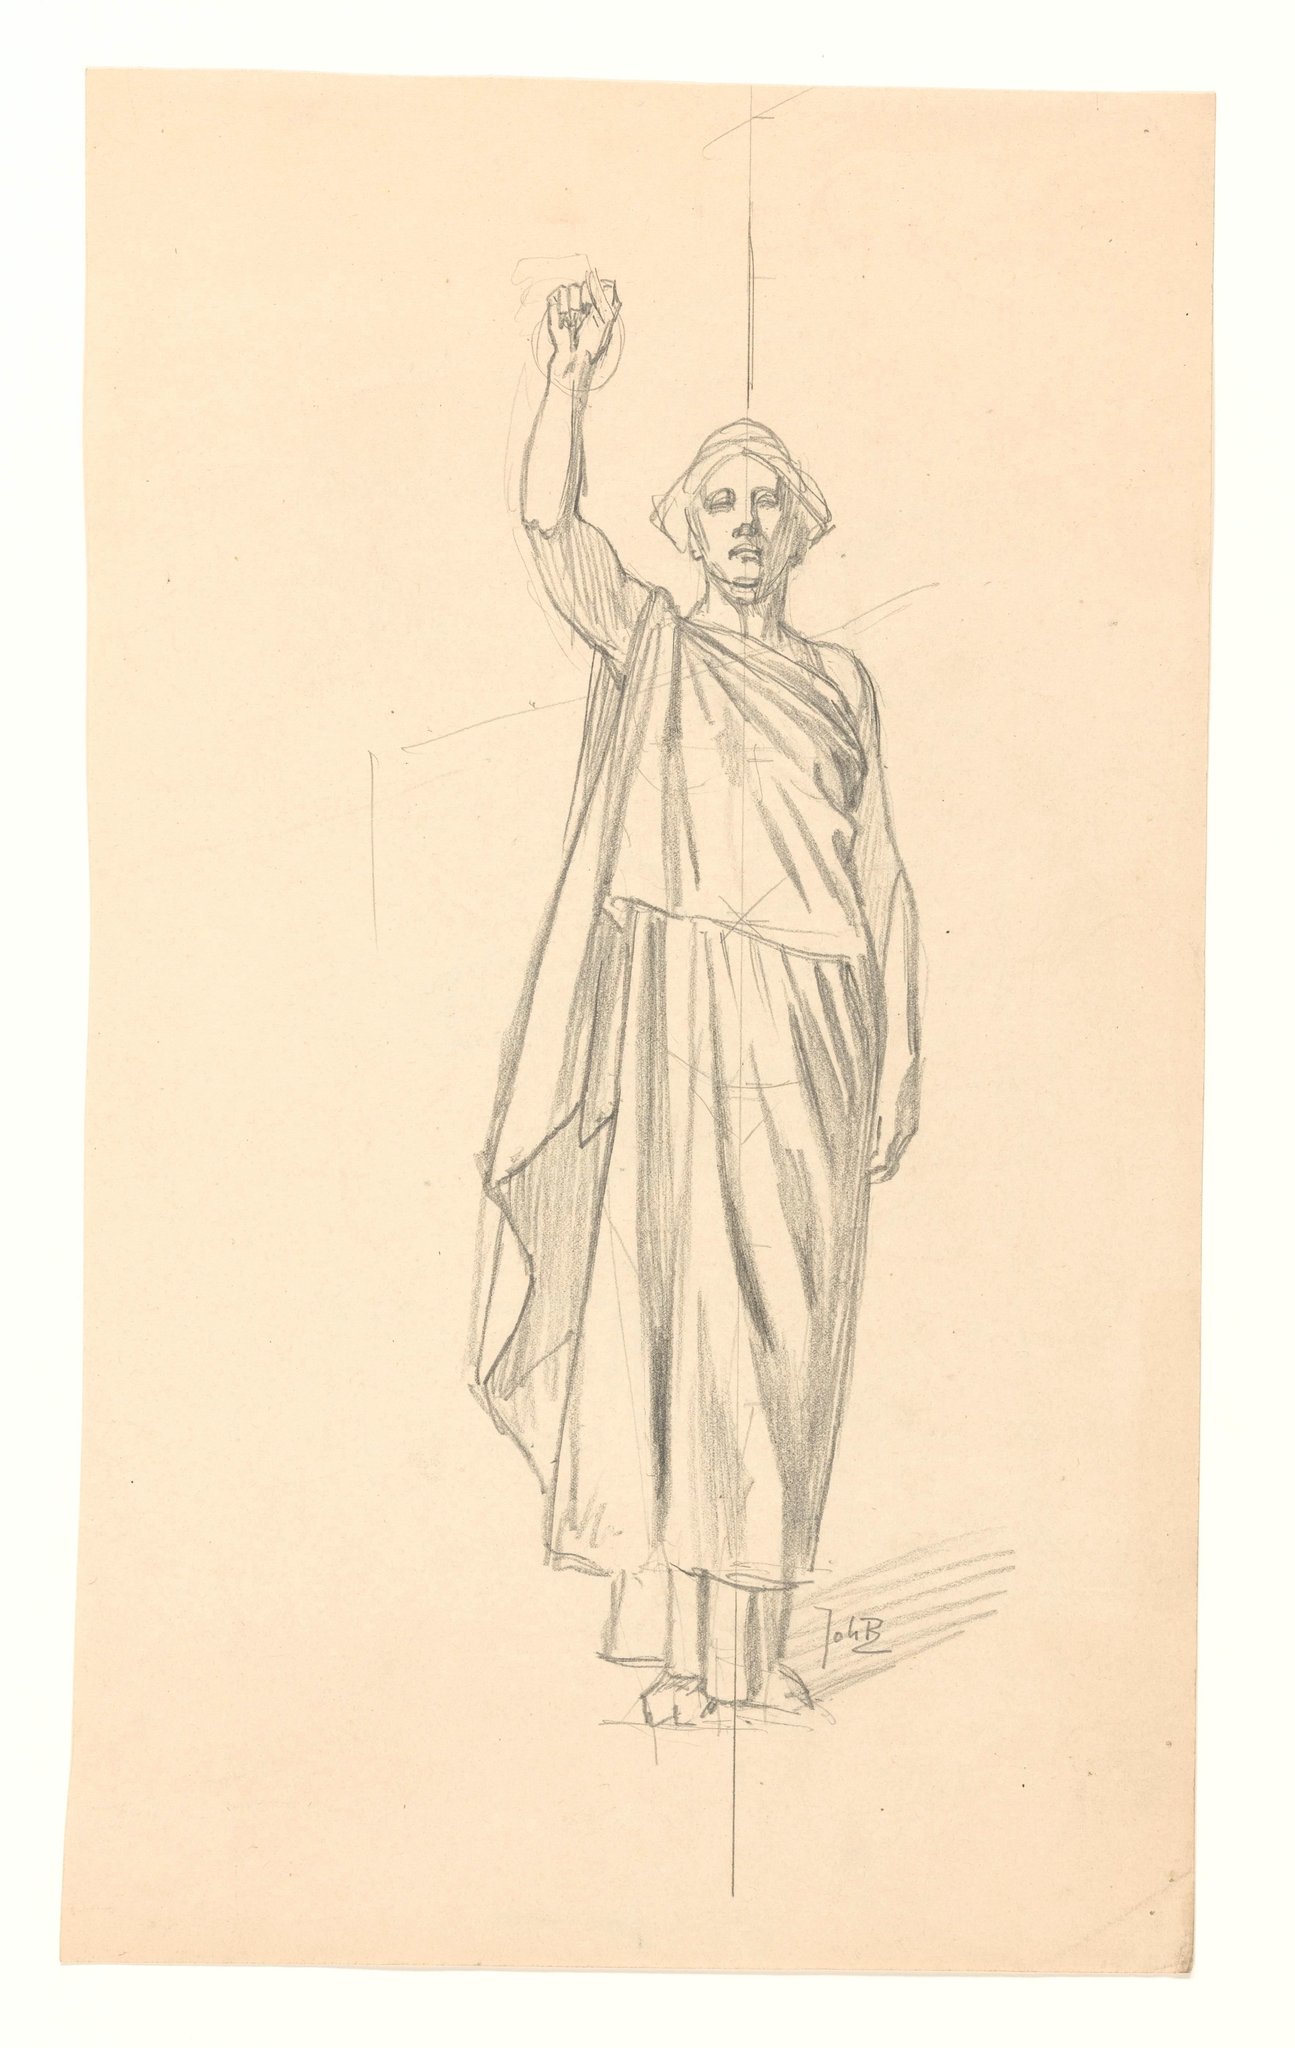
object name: drawing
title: Ontwerp voor illustratie in De Amsterdammer: Justitia (28 Augustus 1920)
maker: johan braakensiek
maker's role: draughtsman, print maker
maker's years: 1858-1940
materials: paper, pencil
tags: political caricatures and satires